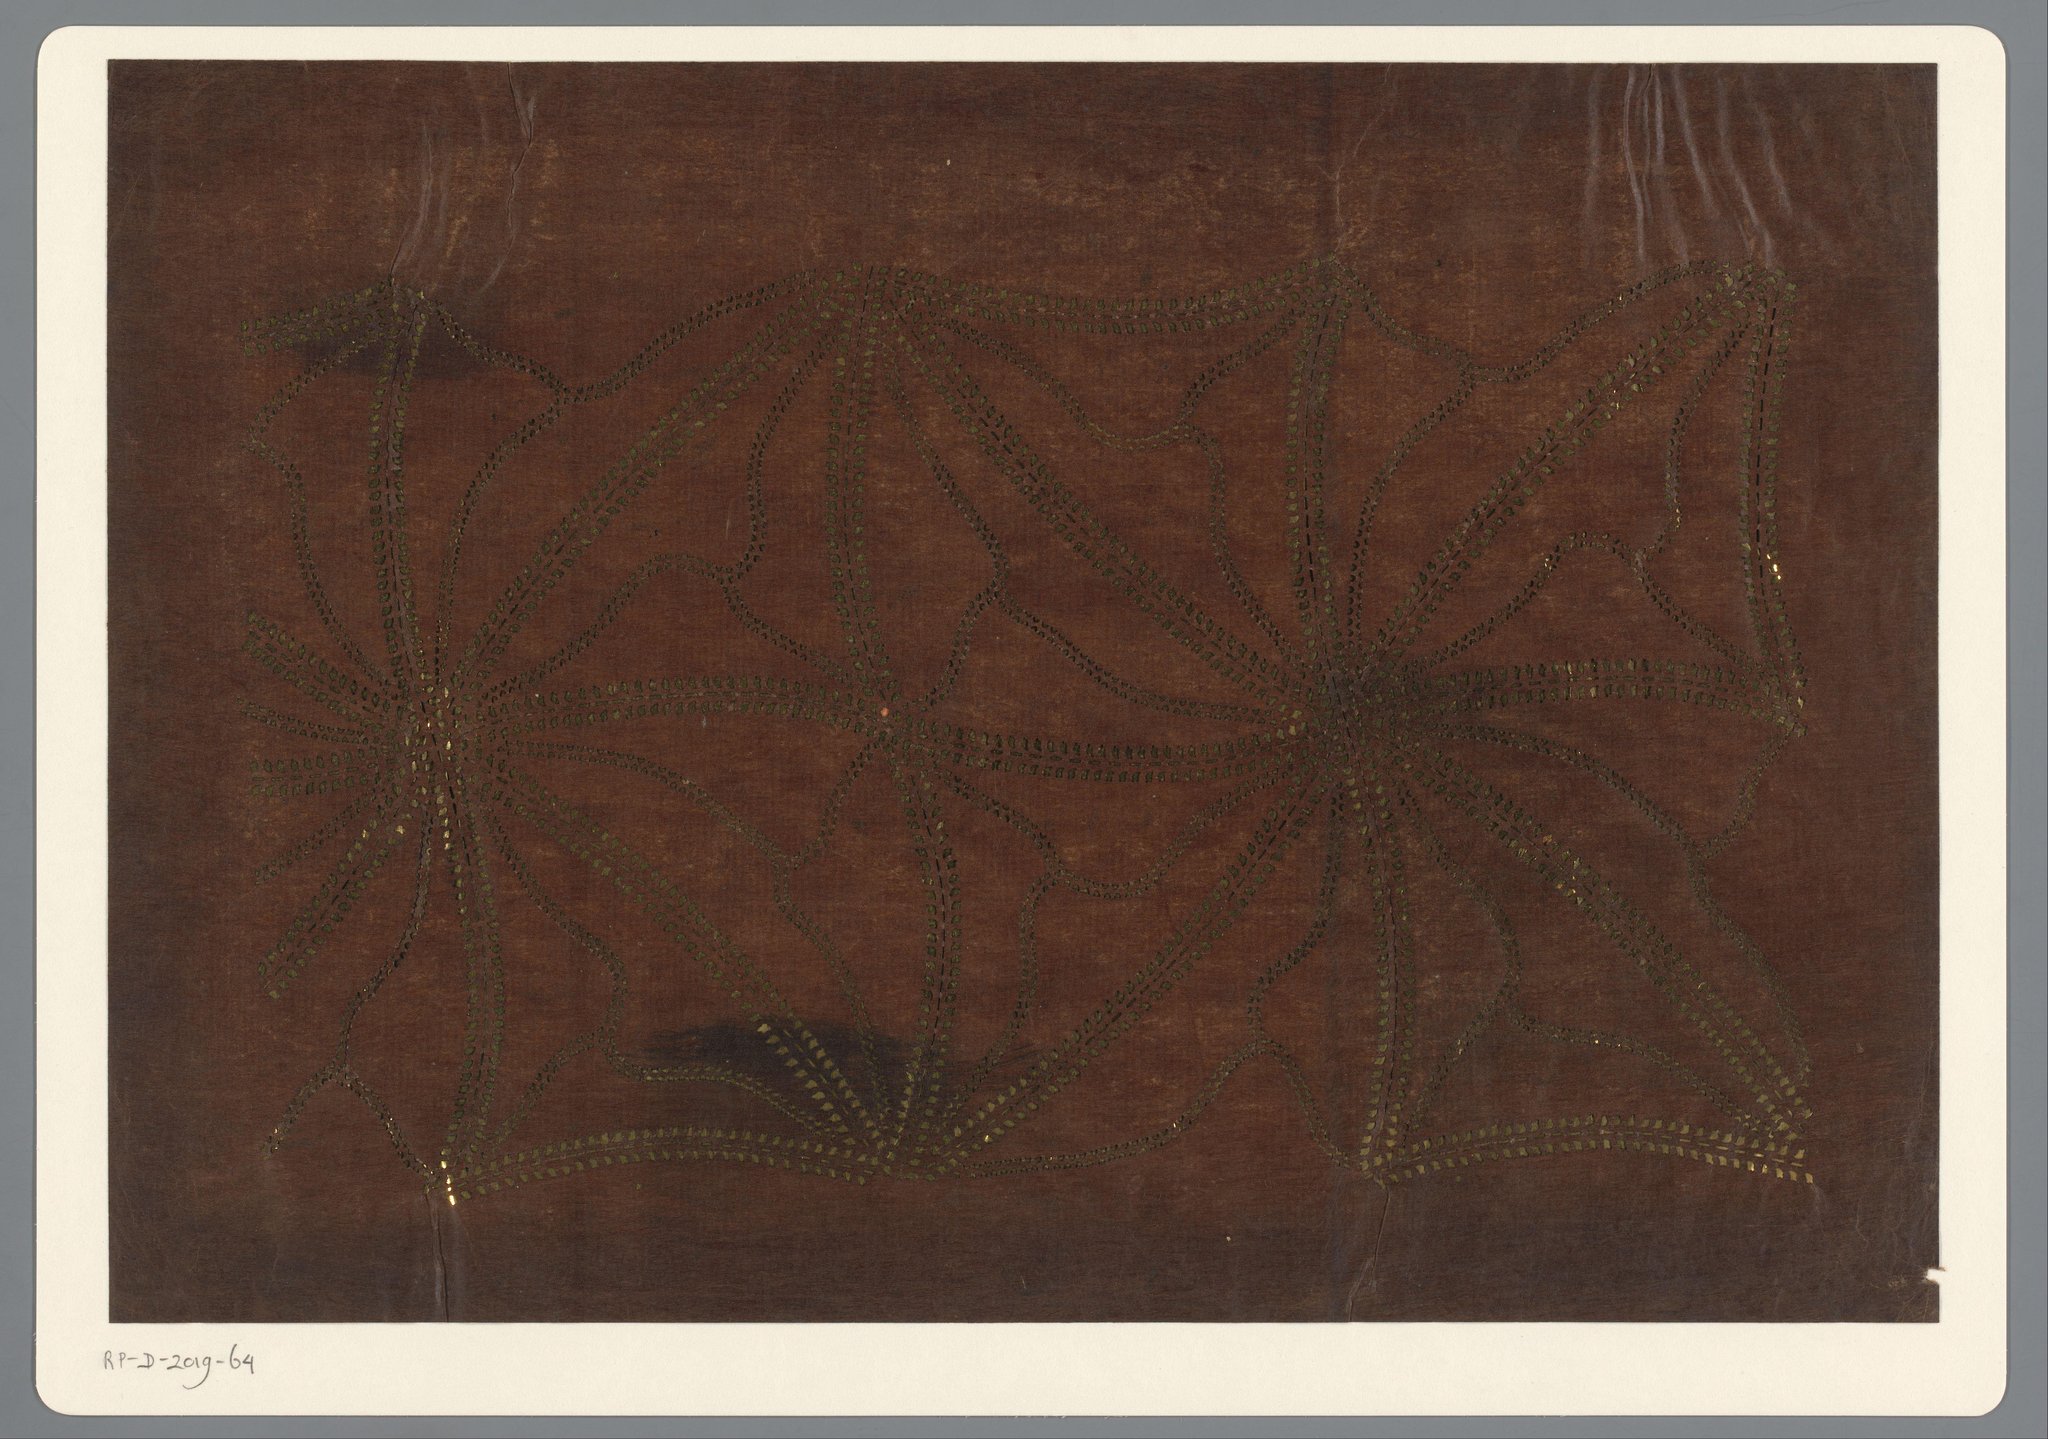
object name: katagami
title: Sjabloon met zeesterren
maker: Anonymous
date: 1800-1909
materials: paper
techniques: pricking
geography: japan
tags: fantasy ornament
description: Japanse sjabloon (katagami) met een uitgeprikt patroon van zeesterren of ritsachtige banen. Achter het sjabloon een vel goudpapier.